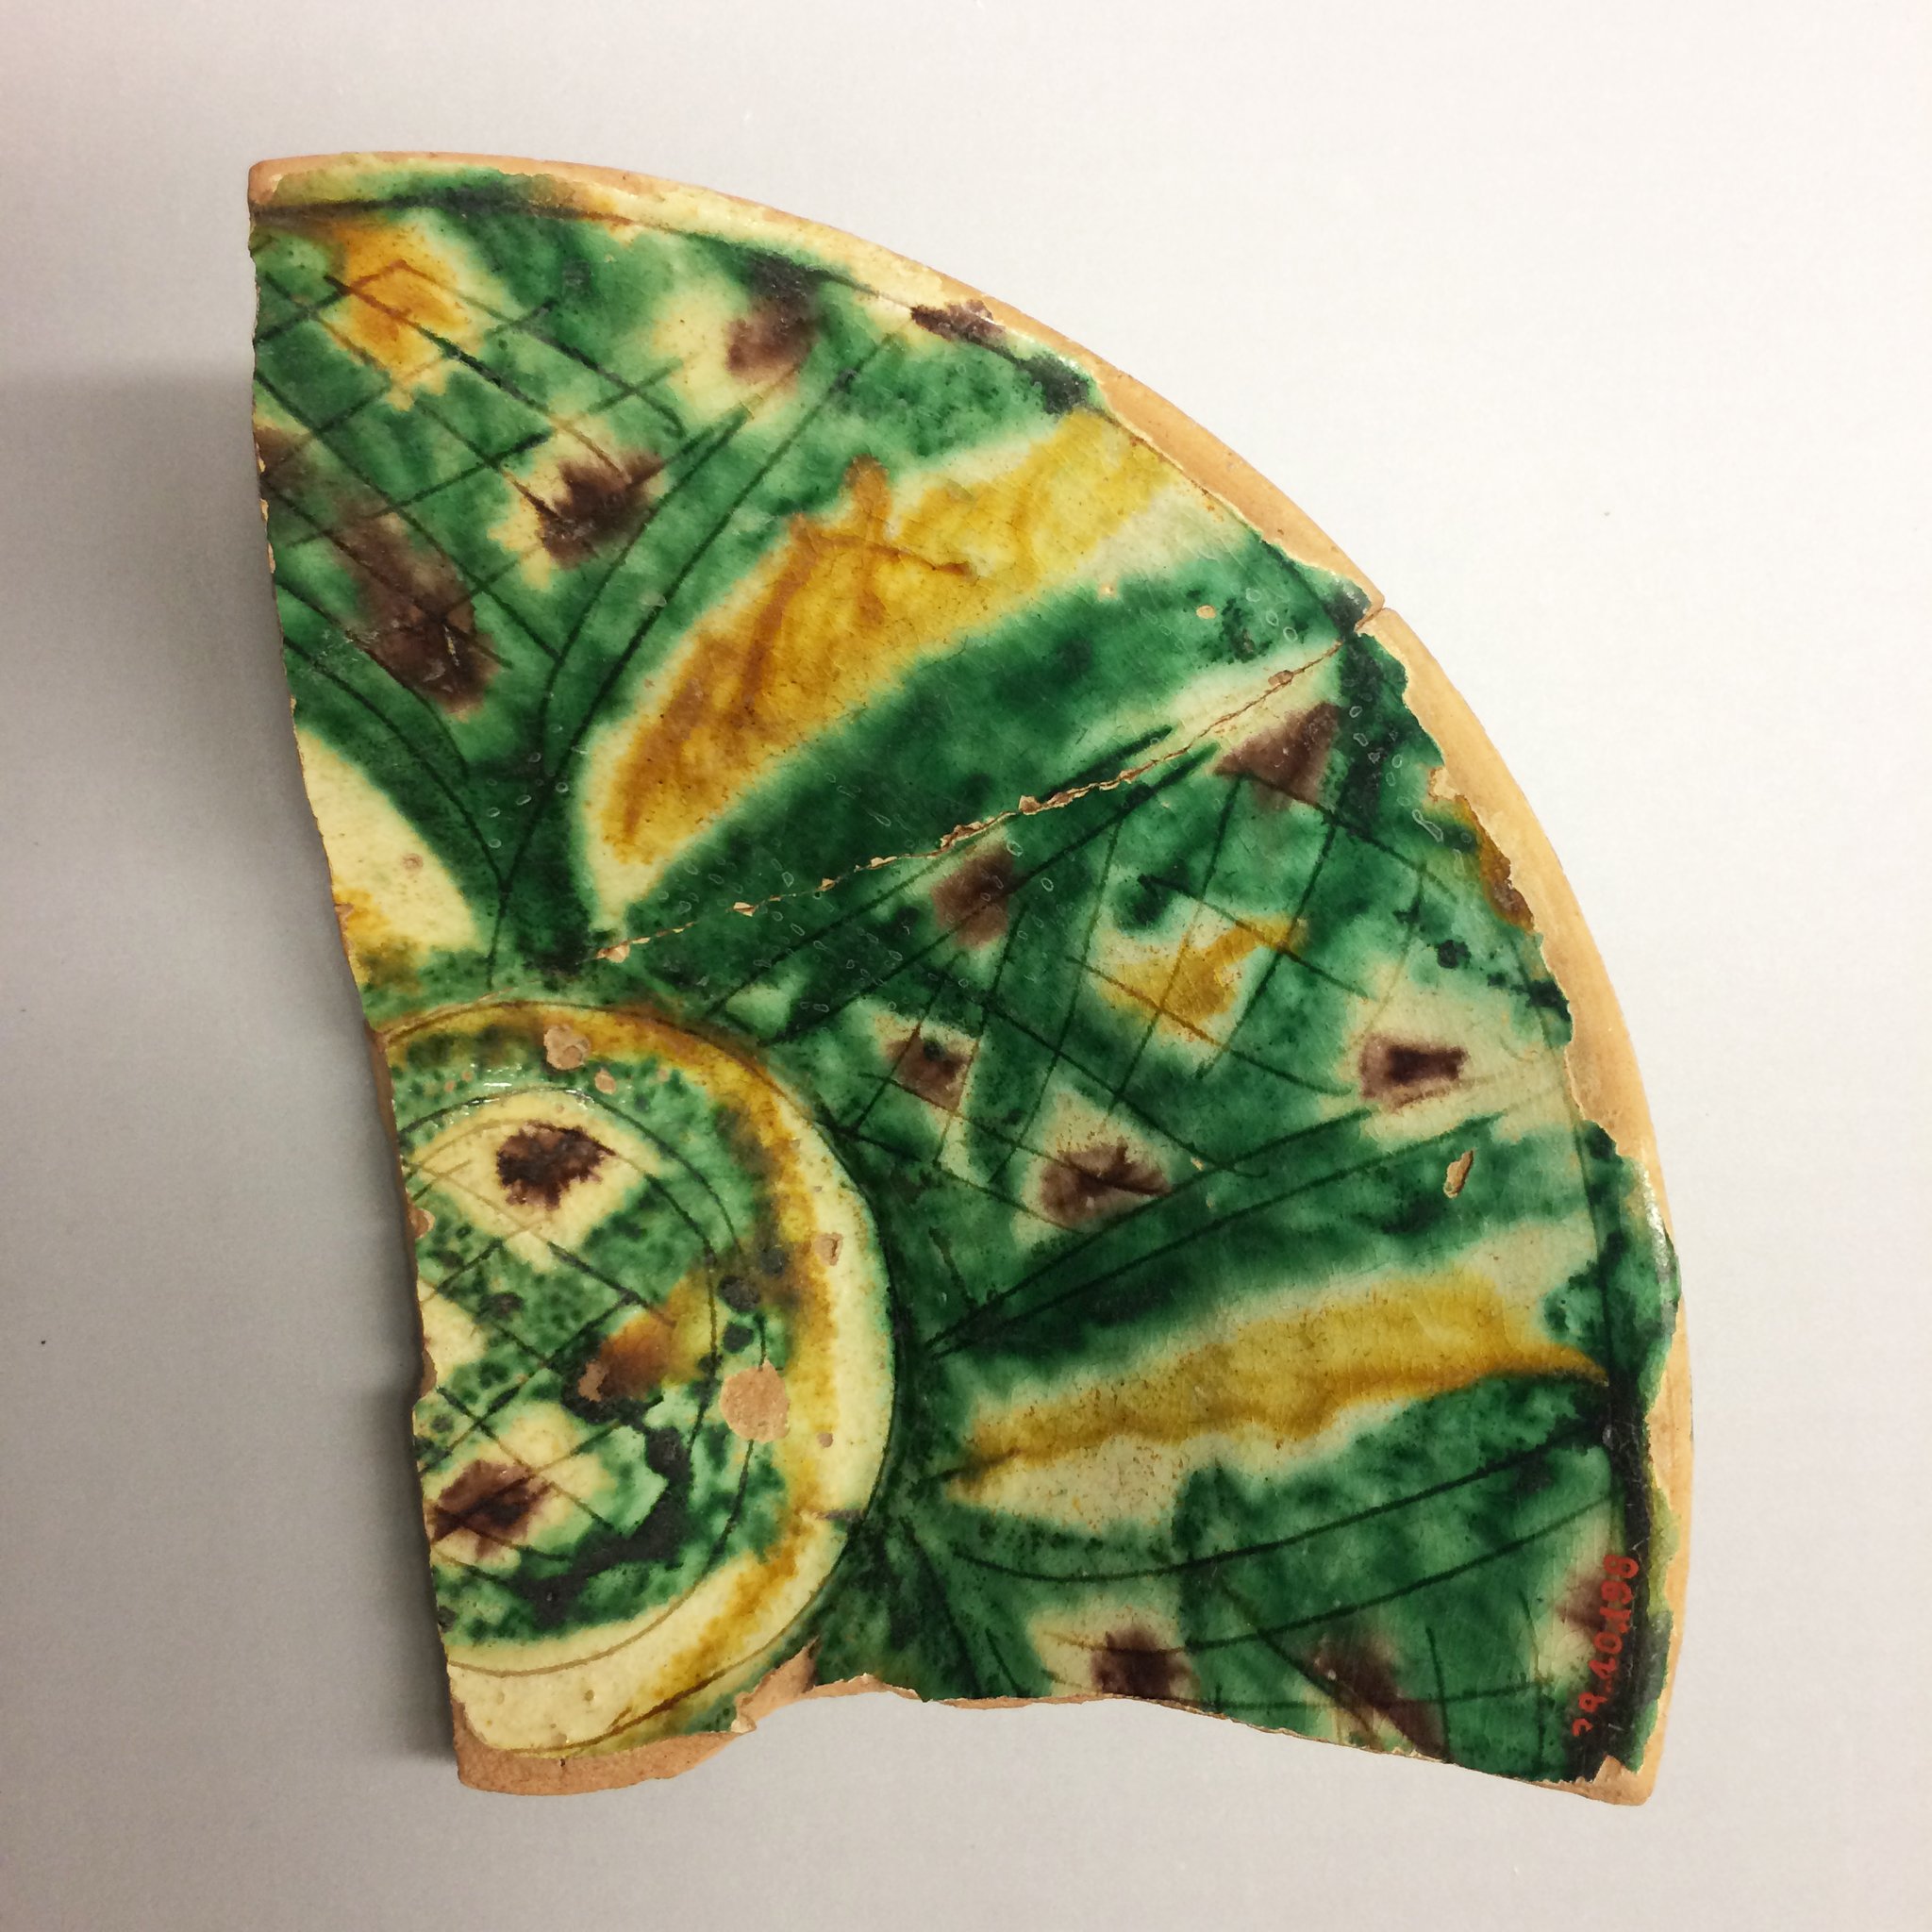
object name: fragment of a bowl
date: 867-1000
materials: earthenware, glaze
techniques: incising, polychrome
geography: iran